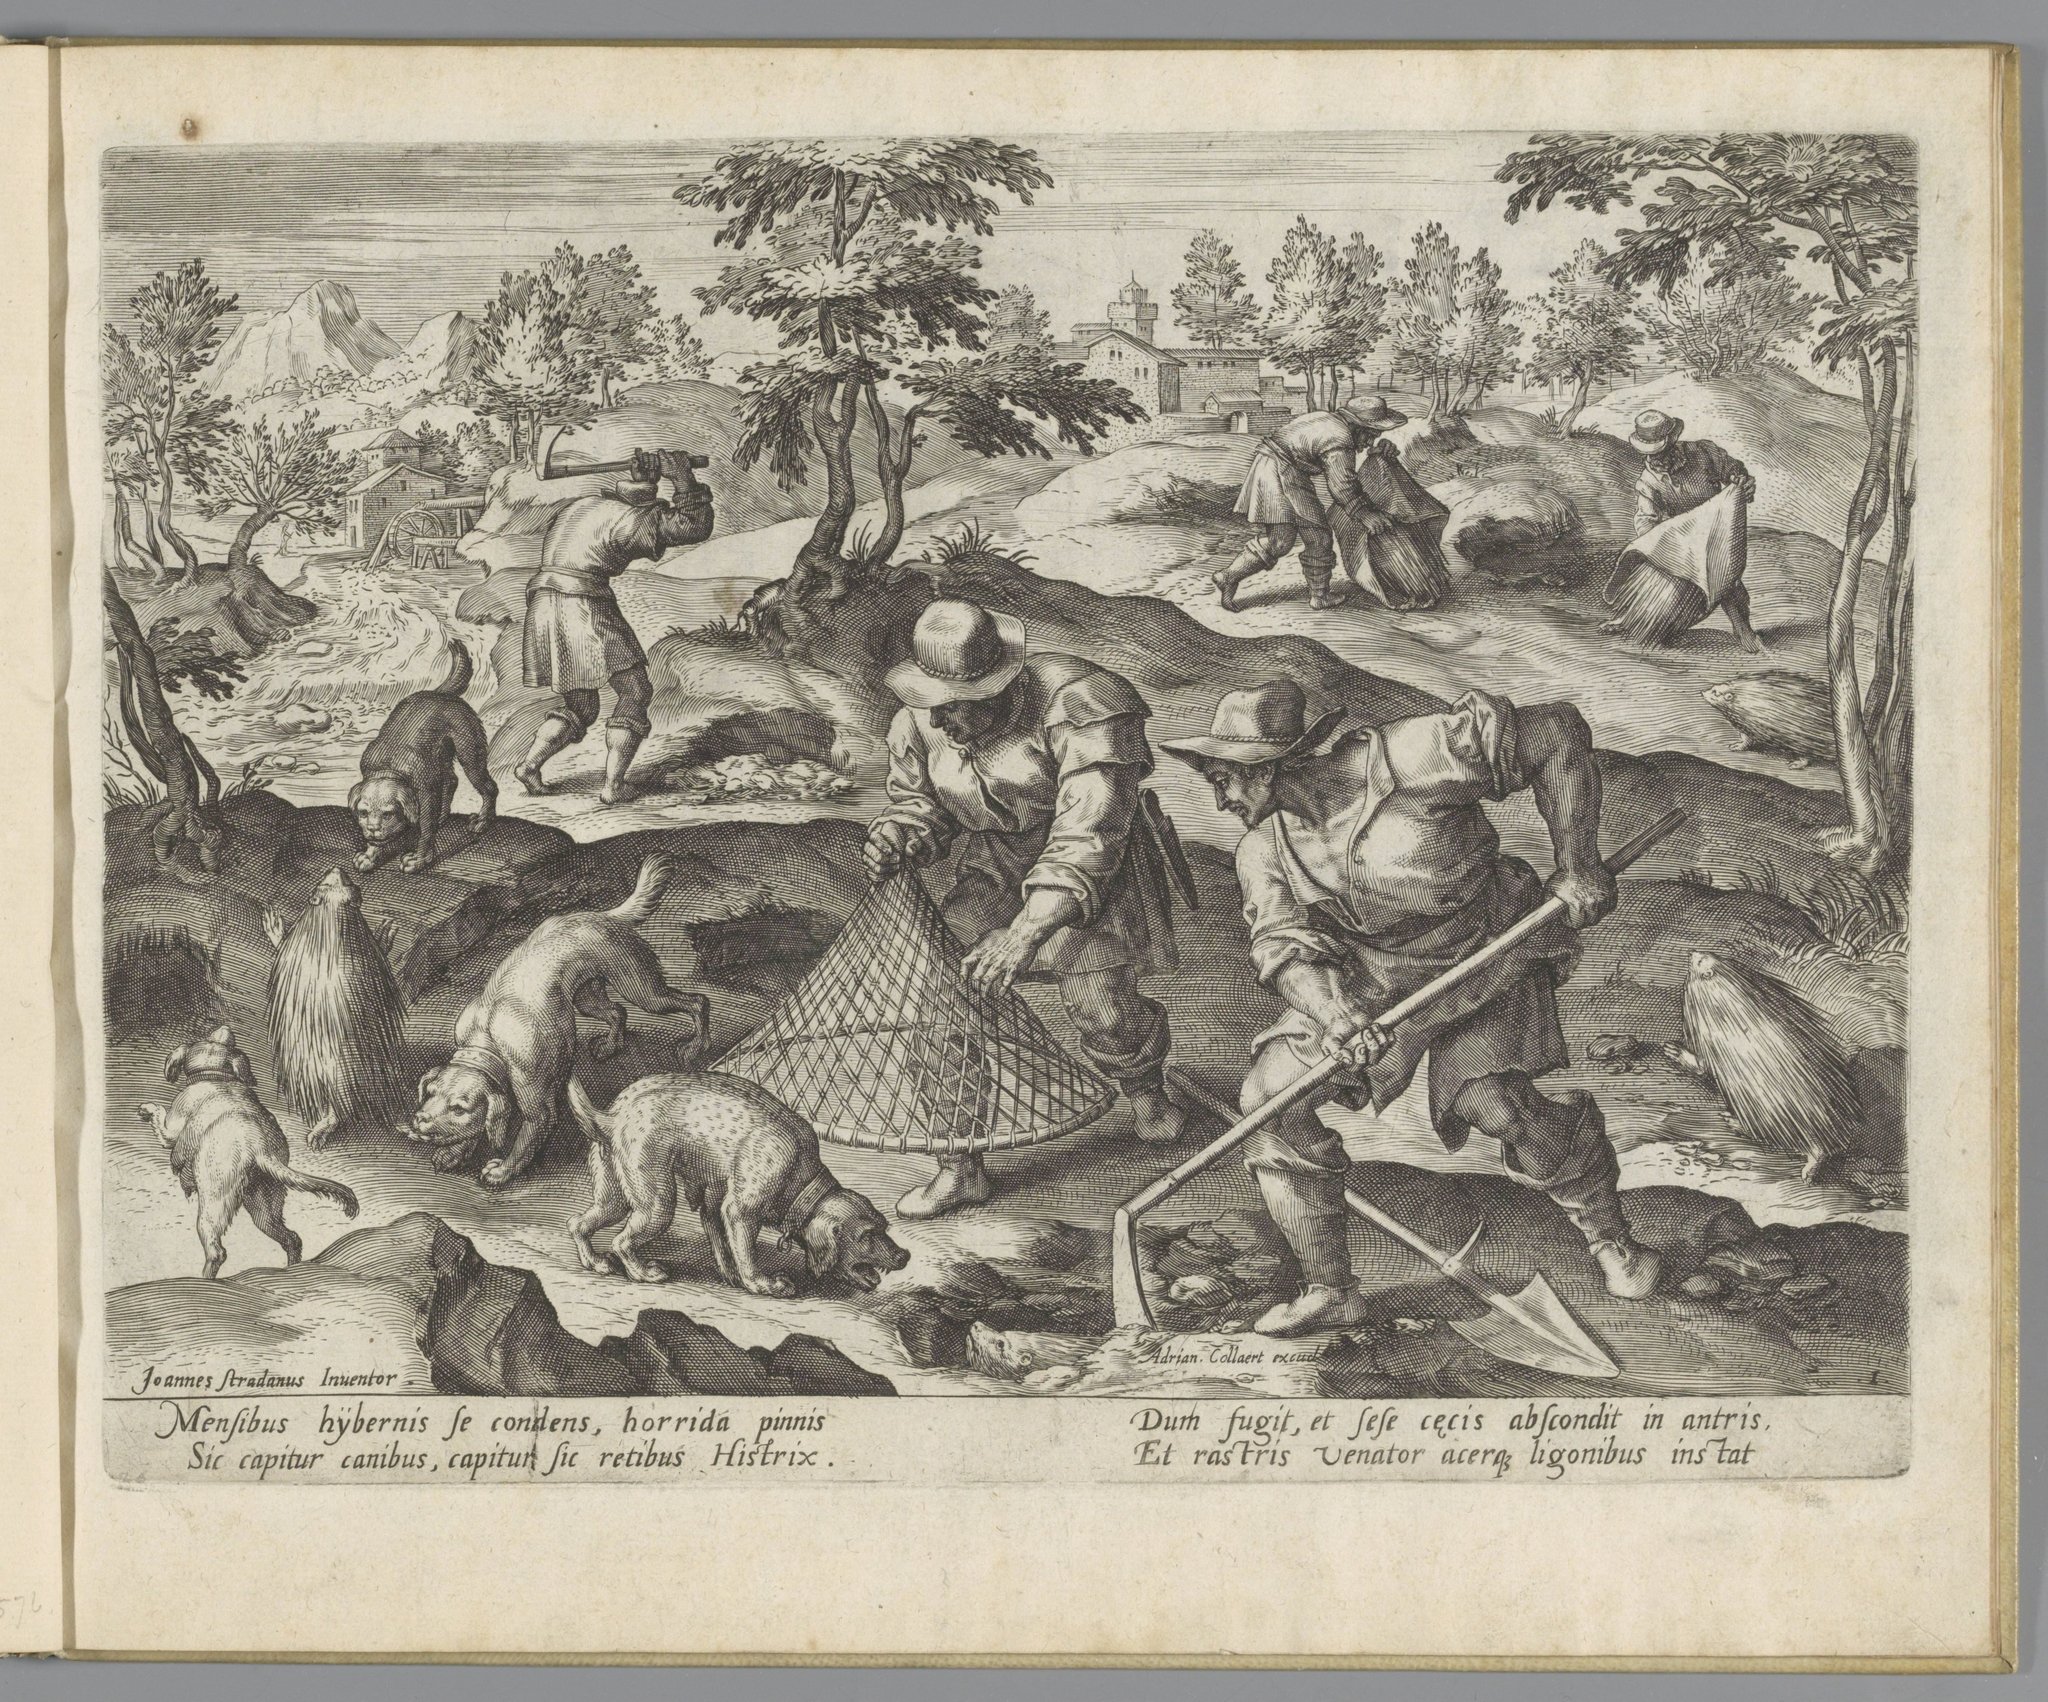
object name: print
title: Jachtscènes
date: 1576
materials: paper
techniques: engraving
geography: antwerp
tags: hunting dogs, other mammals: porcupine, hunter, hunt ~ mammals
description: Landschap met jagers die jagen op stekelvarkens. Ze graven de holen uit en vangen de stekelvarkens onder een net of in zakken. Enkele jachthonden helpen mee. Link op de achtergrond een watermolen. Onder de voorstelling een vierregelig vers in het Latijn. Deze prent maakt deel uit van een album.